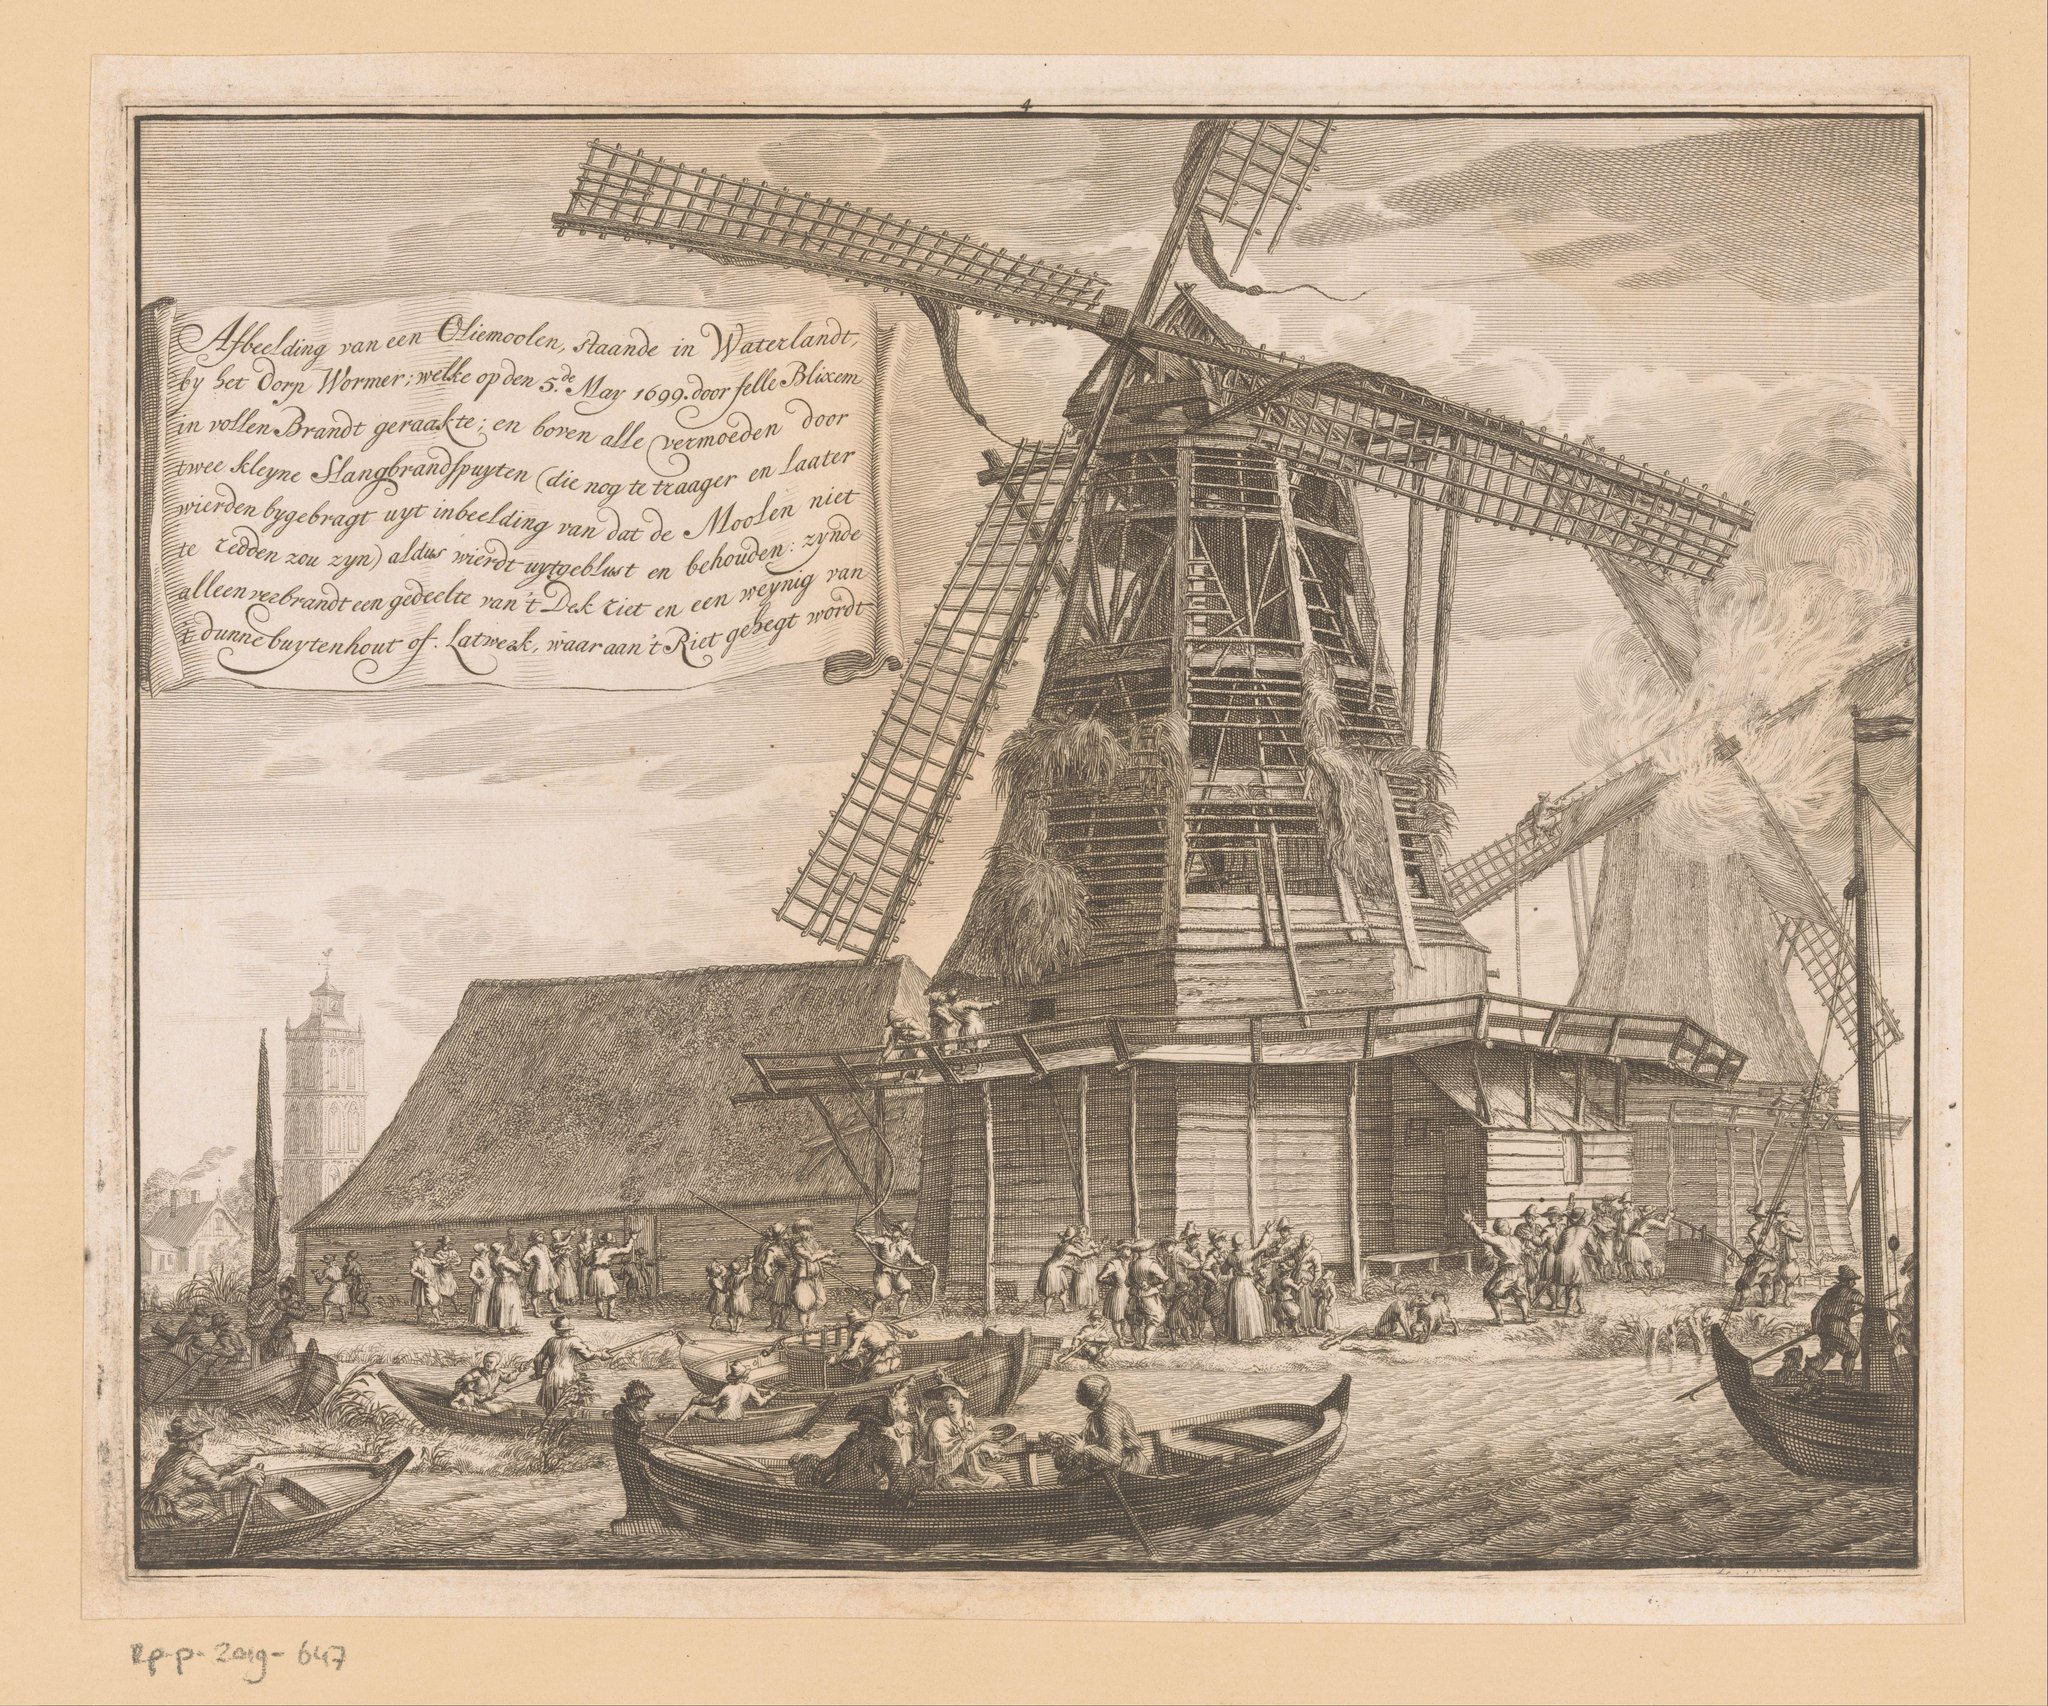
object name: print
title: Brand in oliemolen De Zeug bij Wormer, 1699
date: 1699-1702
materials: paper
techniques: engraving, etching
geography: amsterdam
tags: pump (fire-extinguishing equipment), windmill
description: Zicht op oliemolens De Keizer (voorgrond) en De Zeug (achtergrond) bij Wormer. Oliemolen De Zeug werd op 5 mei 1699 getroffen door de bliksem en vatte vlam. Van oliemolen De Keizer is uit voorzorg het rietdek verwijderd om brand door overwaaiende vonken te voorkomen. Door het blussen met een slangbrandspuit is De Zeug grotendeels bewaard gebleven.